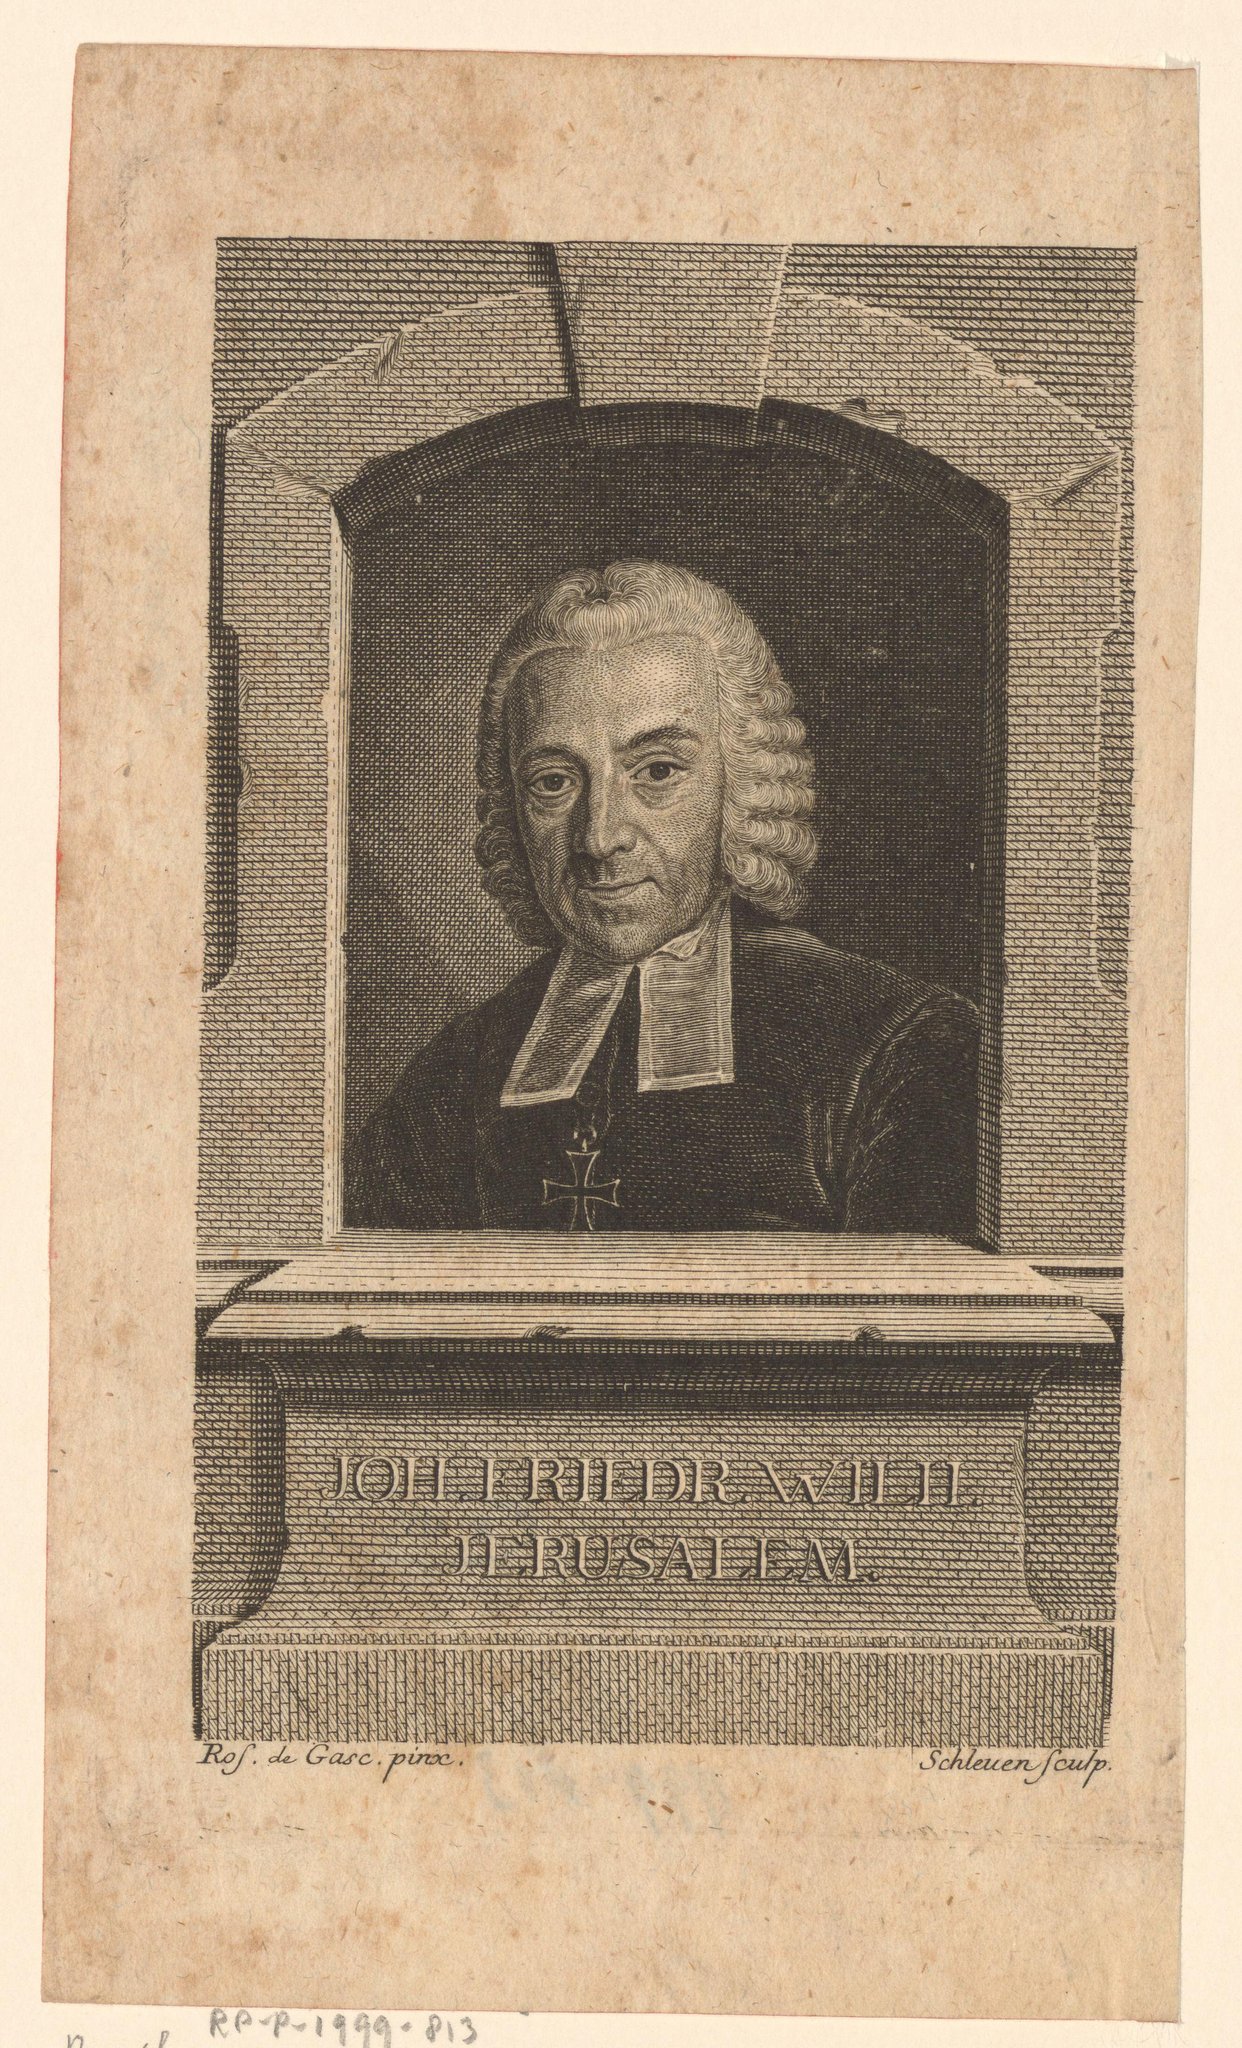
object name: print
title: Portret van Johann Friedrich Wilhelm Jerusalem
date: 1772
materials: paper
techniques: engraving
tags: theologian, historical persons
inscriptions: collector's mark: Lugt 2228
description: Portret van de Luthers theoloog Johann Friedrich Wilhelm Jerusalem: buste in toga met bef, kruis op de borst. In venster, van voren gezien.